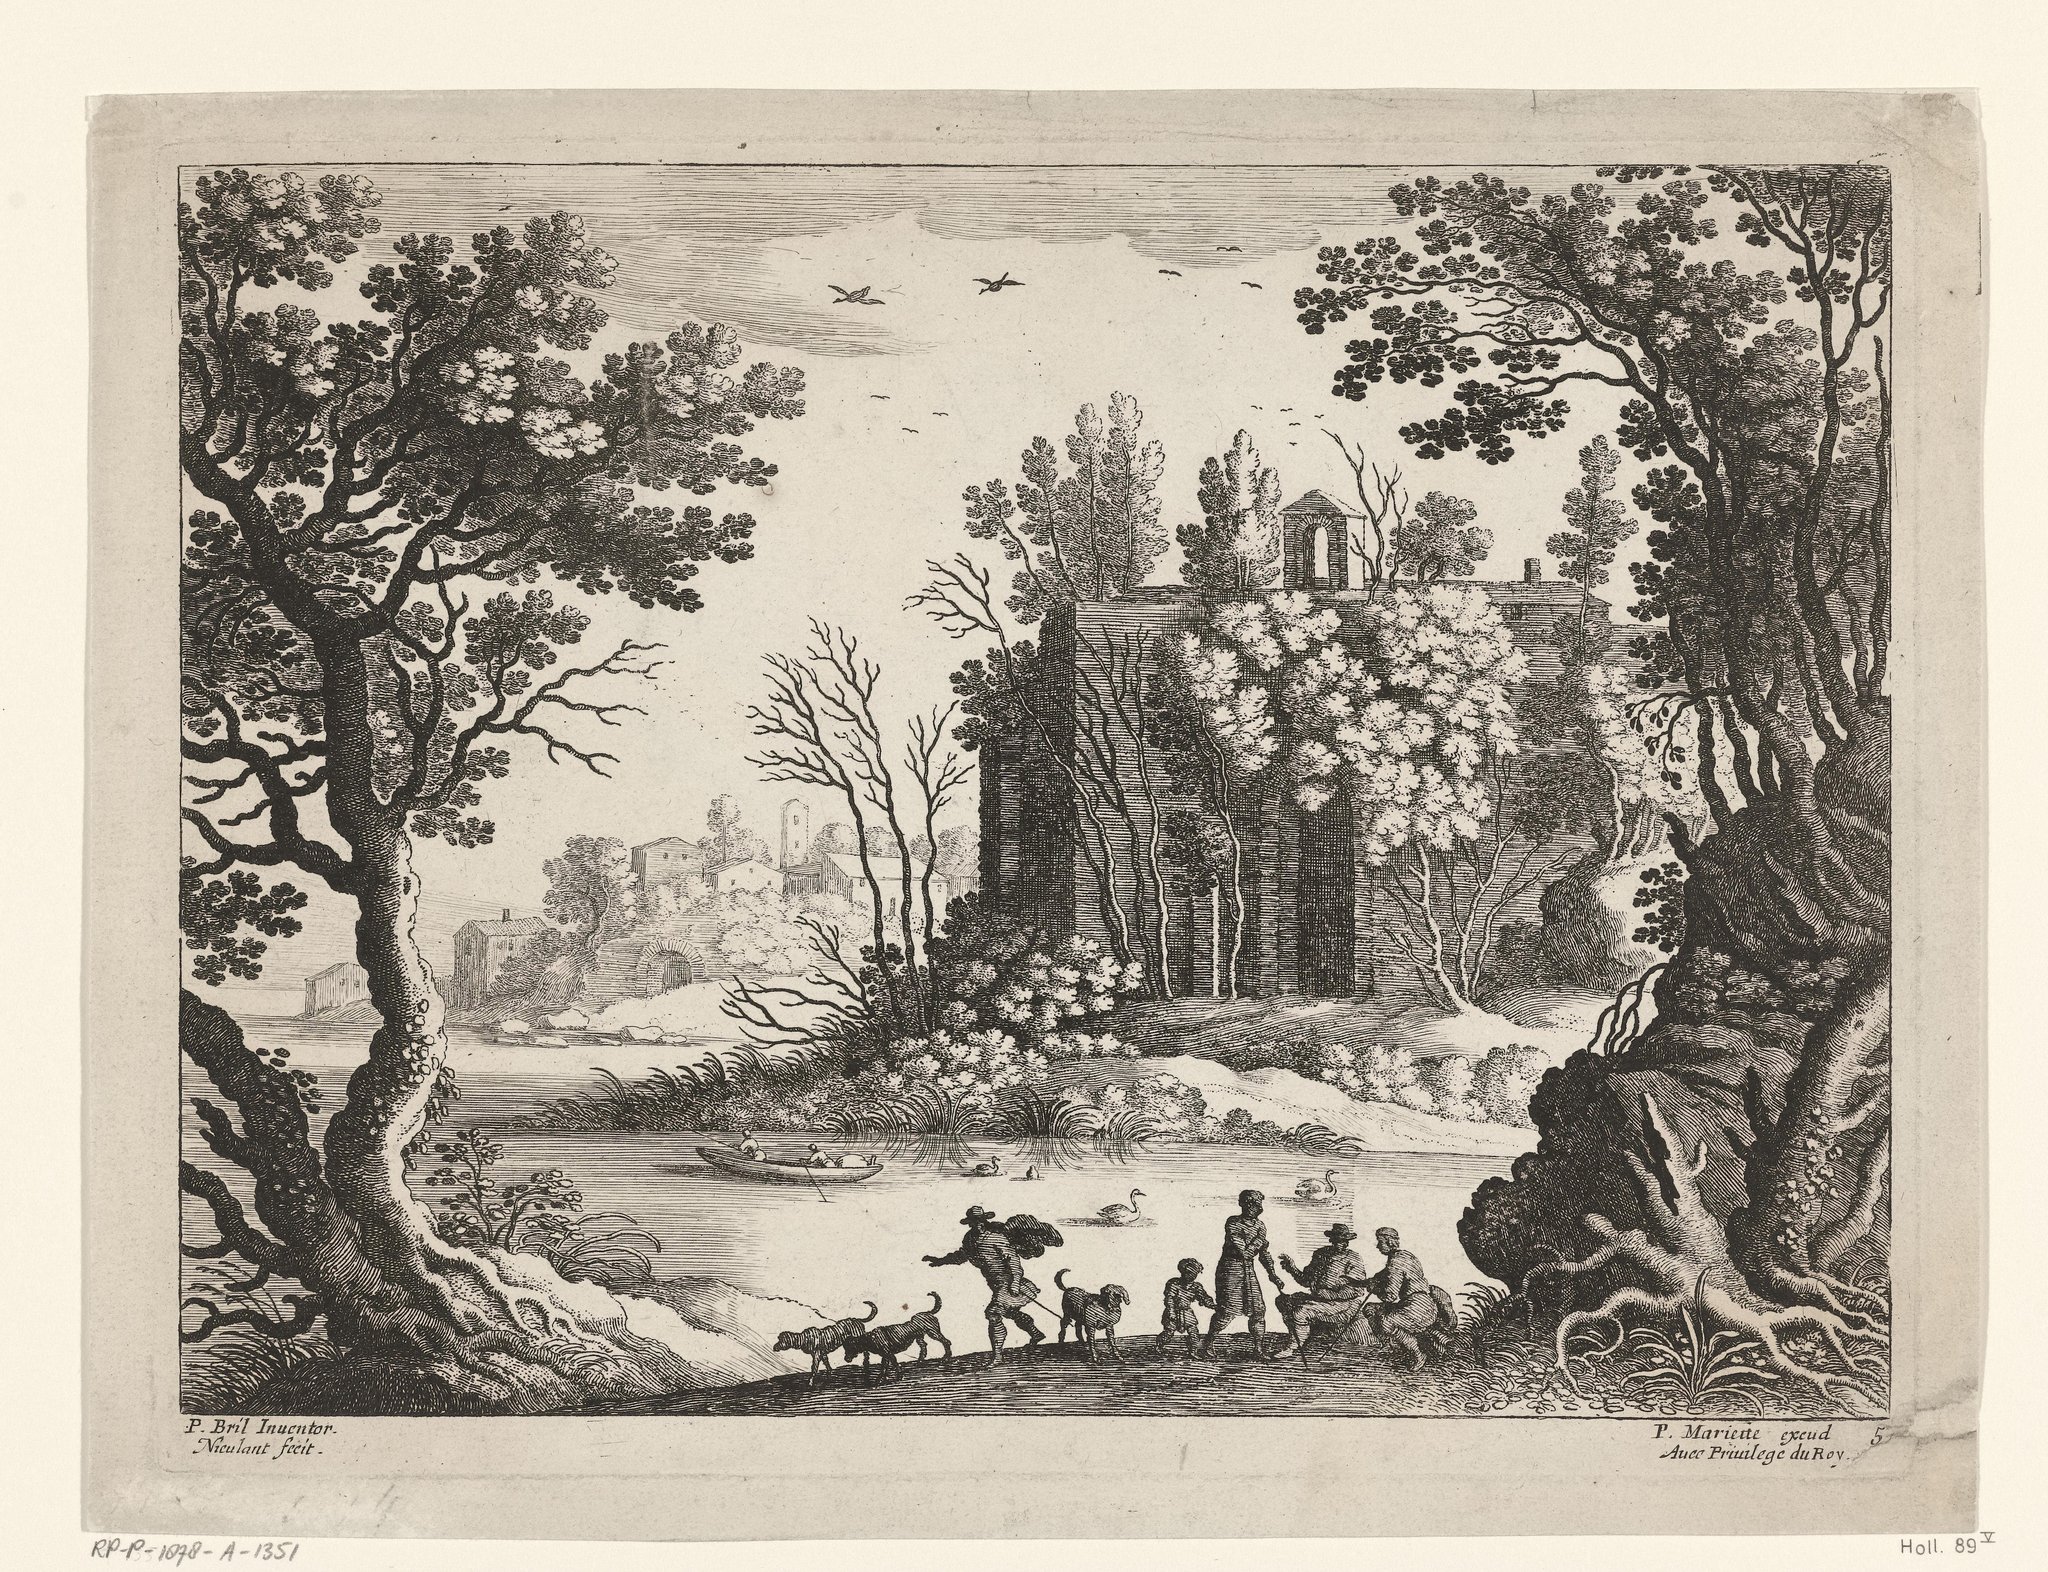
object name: print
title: Italiaanse landschappen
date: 1594-1635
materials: paper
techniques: engraving, etching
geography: paris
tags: river, village, rowing-boat, canoe, etc., dog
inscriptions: collector's mark: Lugt 2228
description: Aan de overzijde van een rivier ligt een hoog gebouw door bomen omringd. Links op de oever ligt een dorp. Op de voorgrond enkele mannen, een kind en honden. Op het water vaart een roeiboot. Prent uit een serie Italiaanse landschappen.